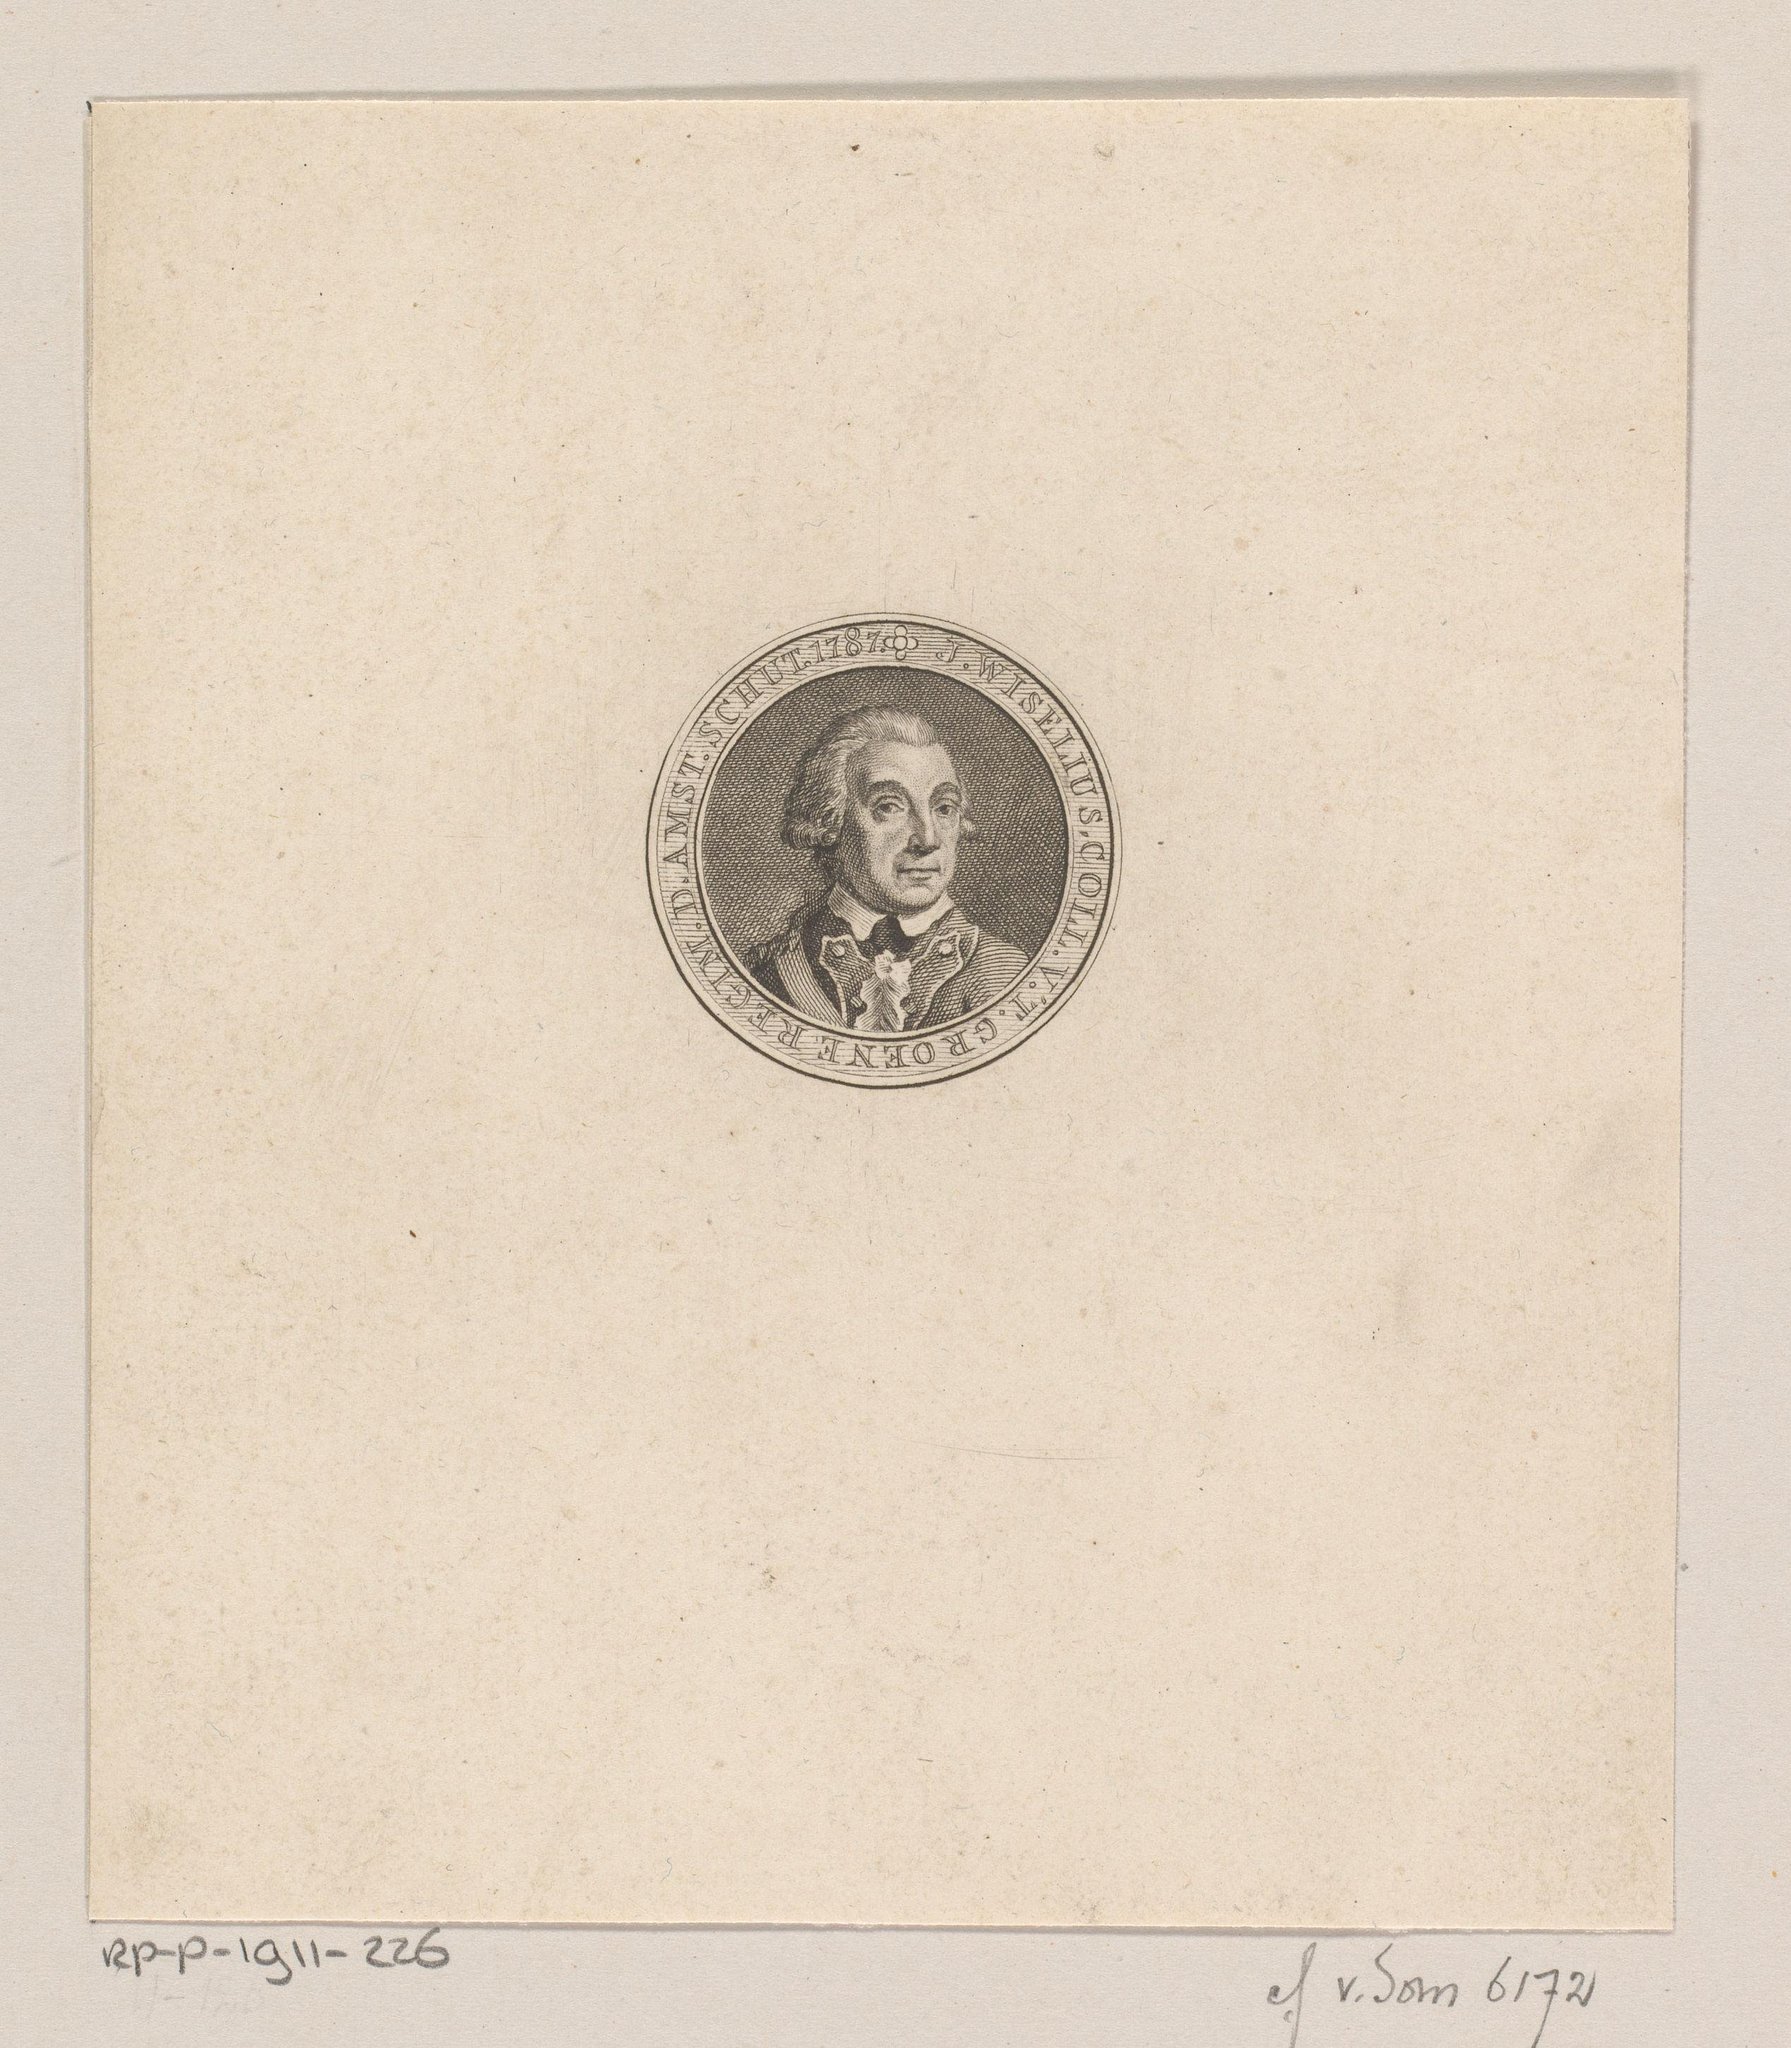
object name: print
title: Portretten van patriotten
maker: abraham jacobsz. hulk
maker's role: print maker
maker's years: 1751-1817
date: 1787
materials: paper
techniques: engraving, etching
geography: paris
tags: historical persons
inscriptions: collector's mark: Lugt 2228